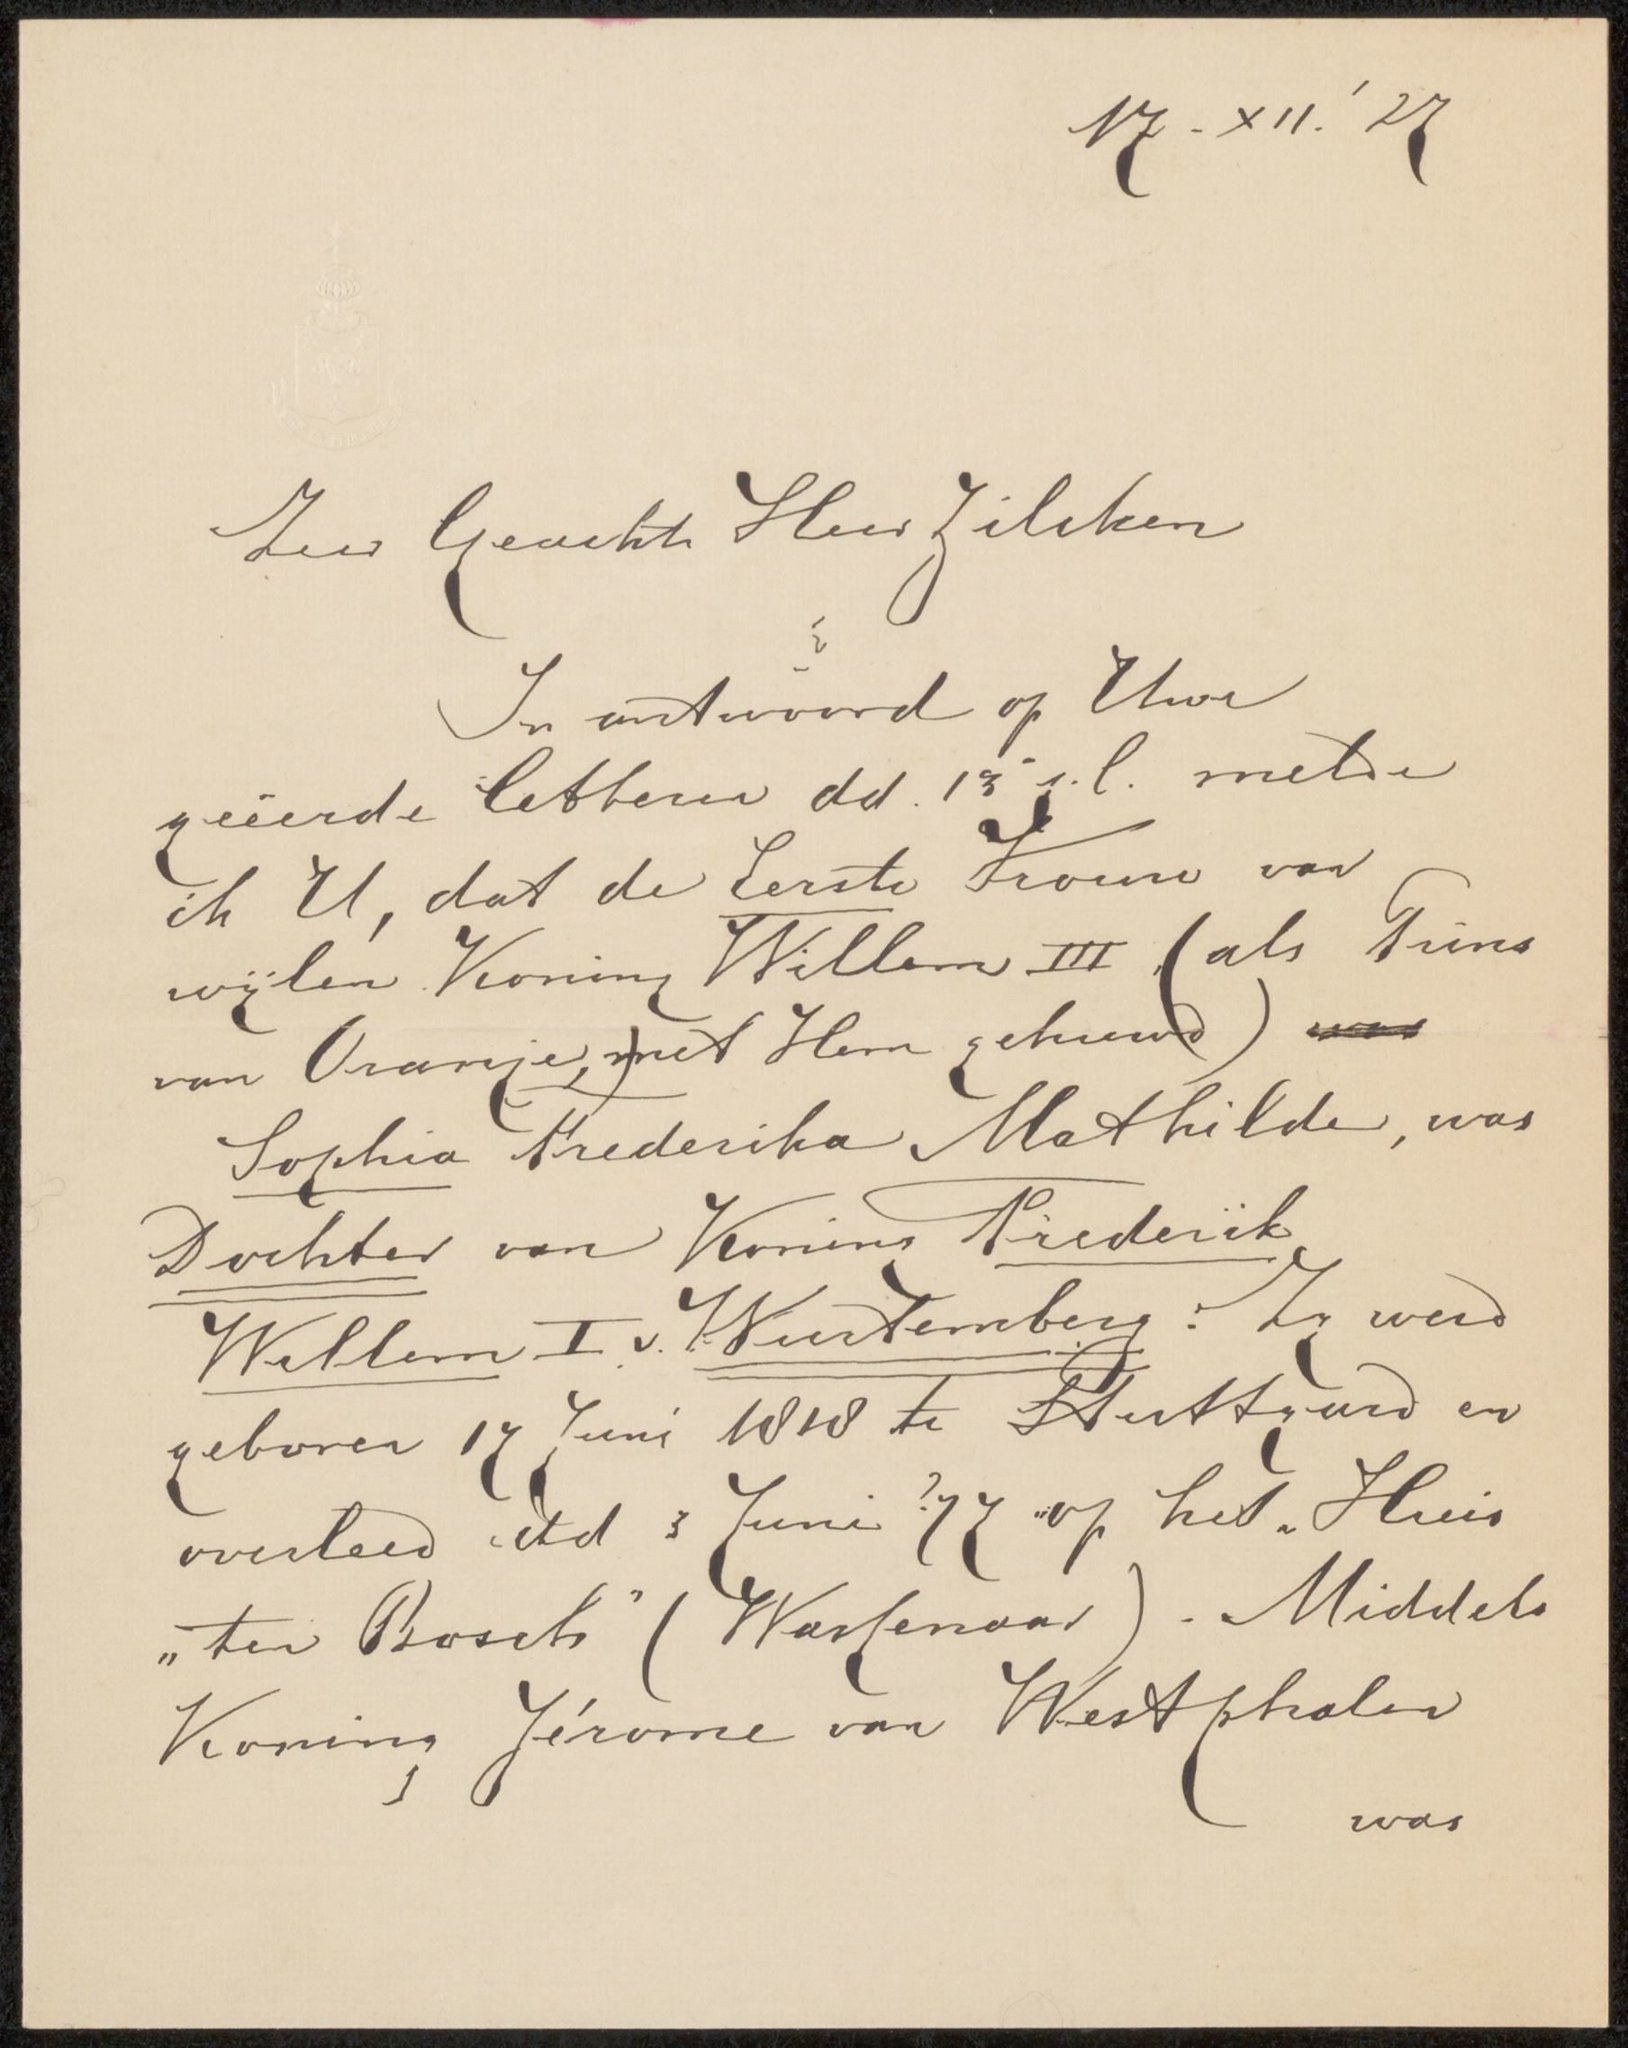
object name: letter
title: Brief aan Philip Zilcken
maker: françois de bas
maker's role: historicus, kolonel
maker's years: 1840-1931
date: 1927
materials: ink, paper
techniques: pen, printing, writing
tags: sophia frederika mathilda van württemberg, painter, draughtsman, philip zilcken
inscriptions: collector's mark: ‘RPK’, coat of arms: ‘ORA ET PERSEVERA’, watermark